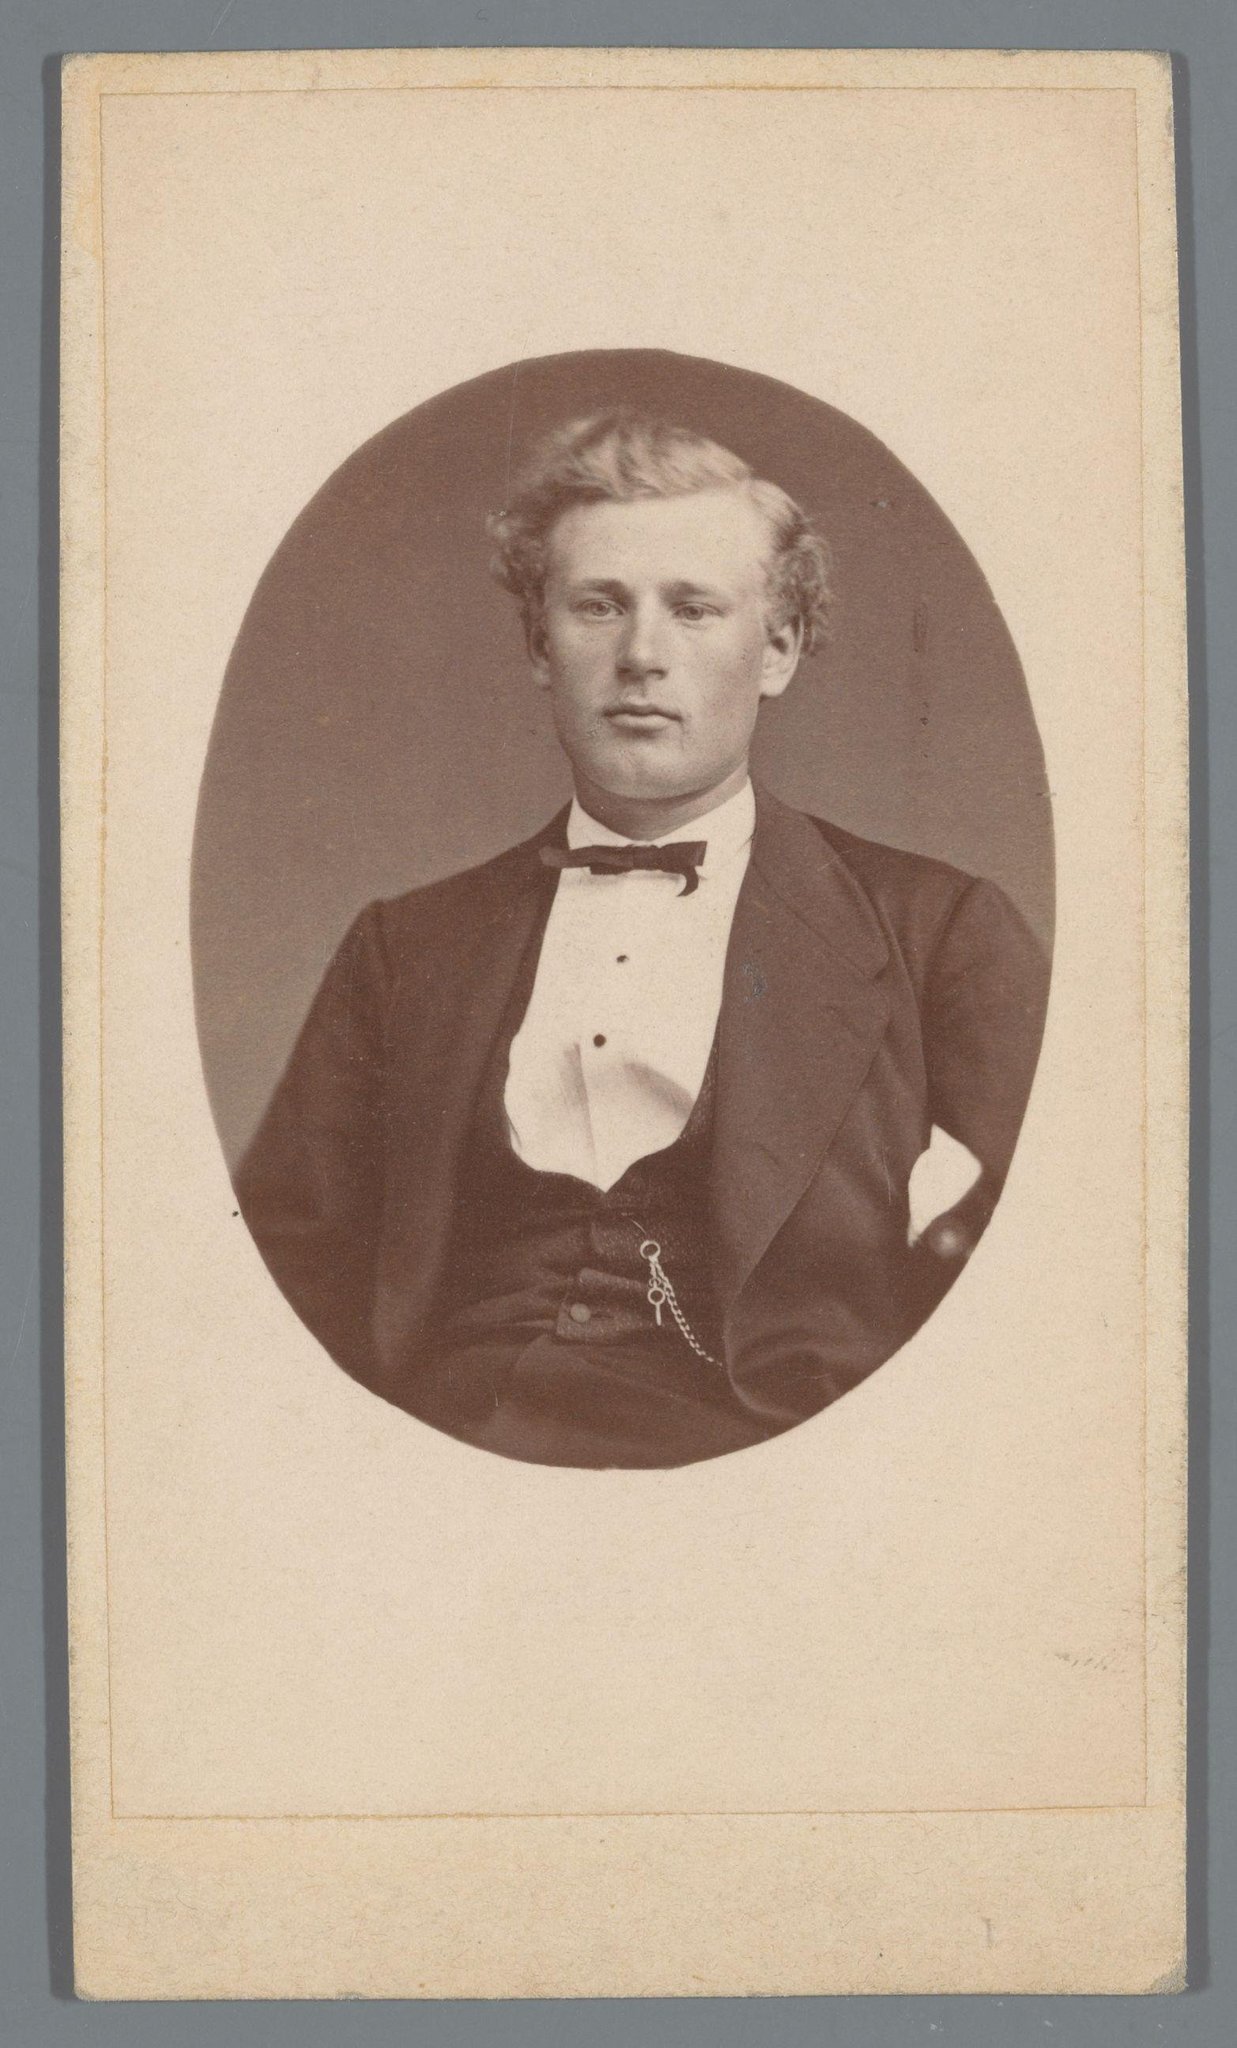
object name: carte de visite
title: Portret van een onbekende jonge man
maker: anders anderzon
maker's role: fotograaf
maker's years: 1834-1916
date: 1860-1880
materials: cardboard, paper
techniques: albumen print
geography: strängnäs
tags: youth, adolescent, anonymous historical person portrayed